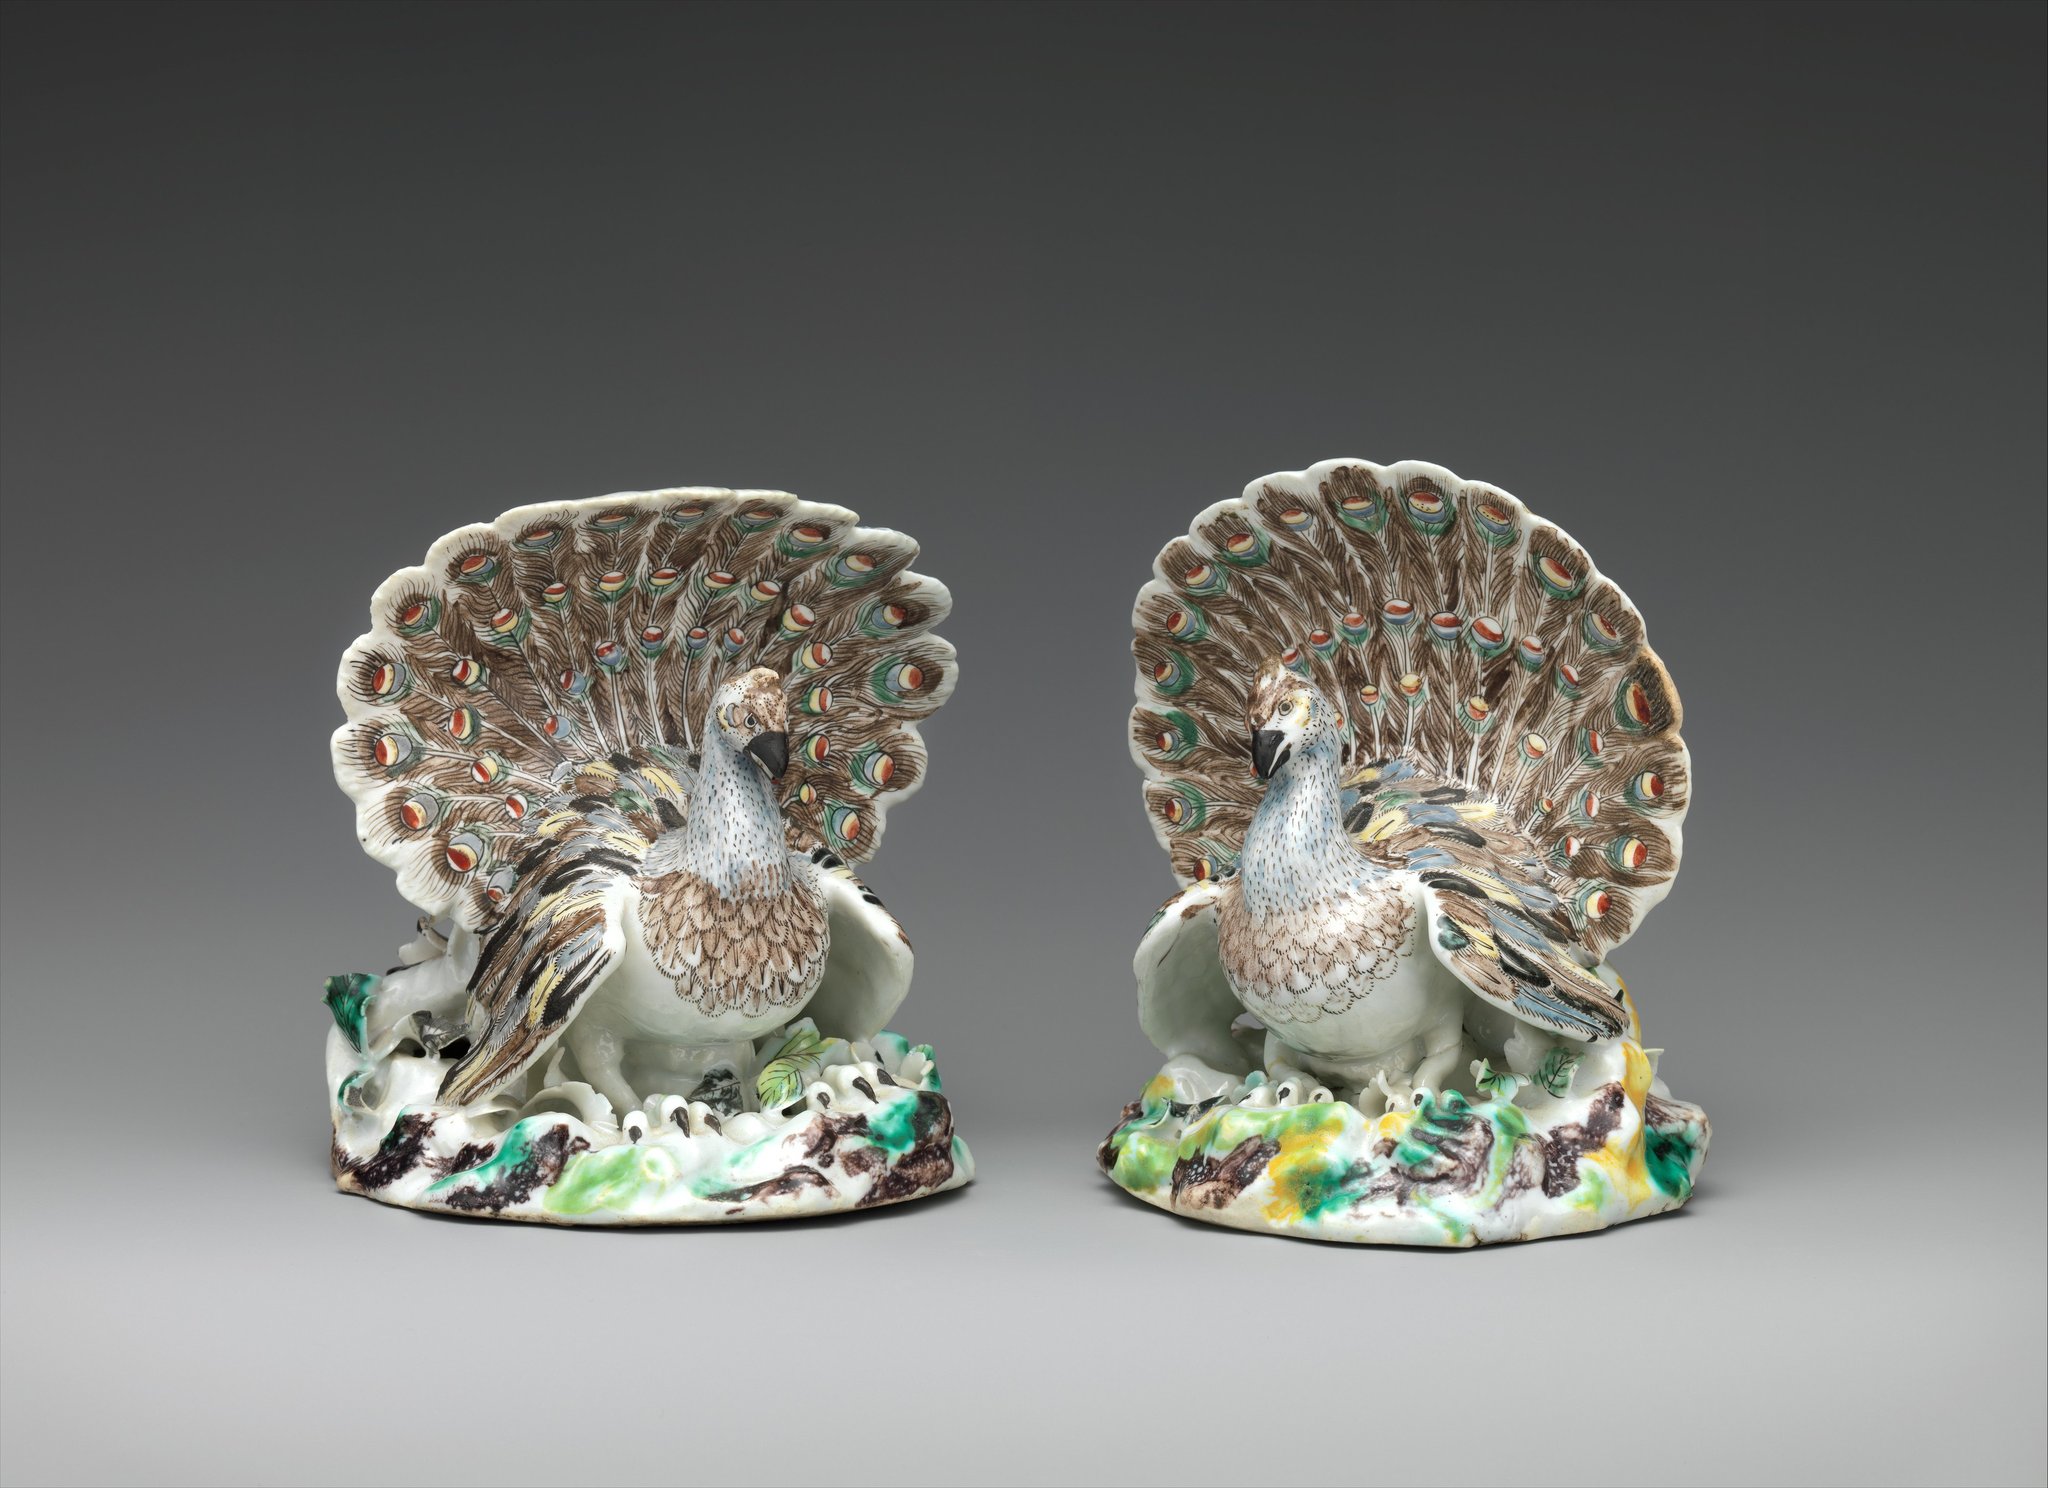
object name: figure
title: Pair of peacocks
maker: villeroy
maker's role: factory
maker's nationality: french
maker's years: 1734-1748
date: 1745-1750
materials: soft paste porcelain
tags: peacocks